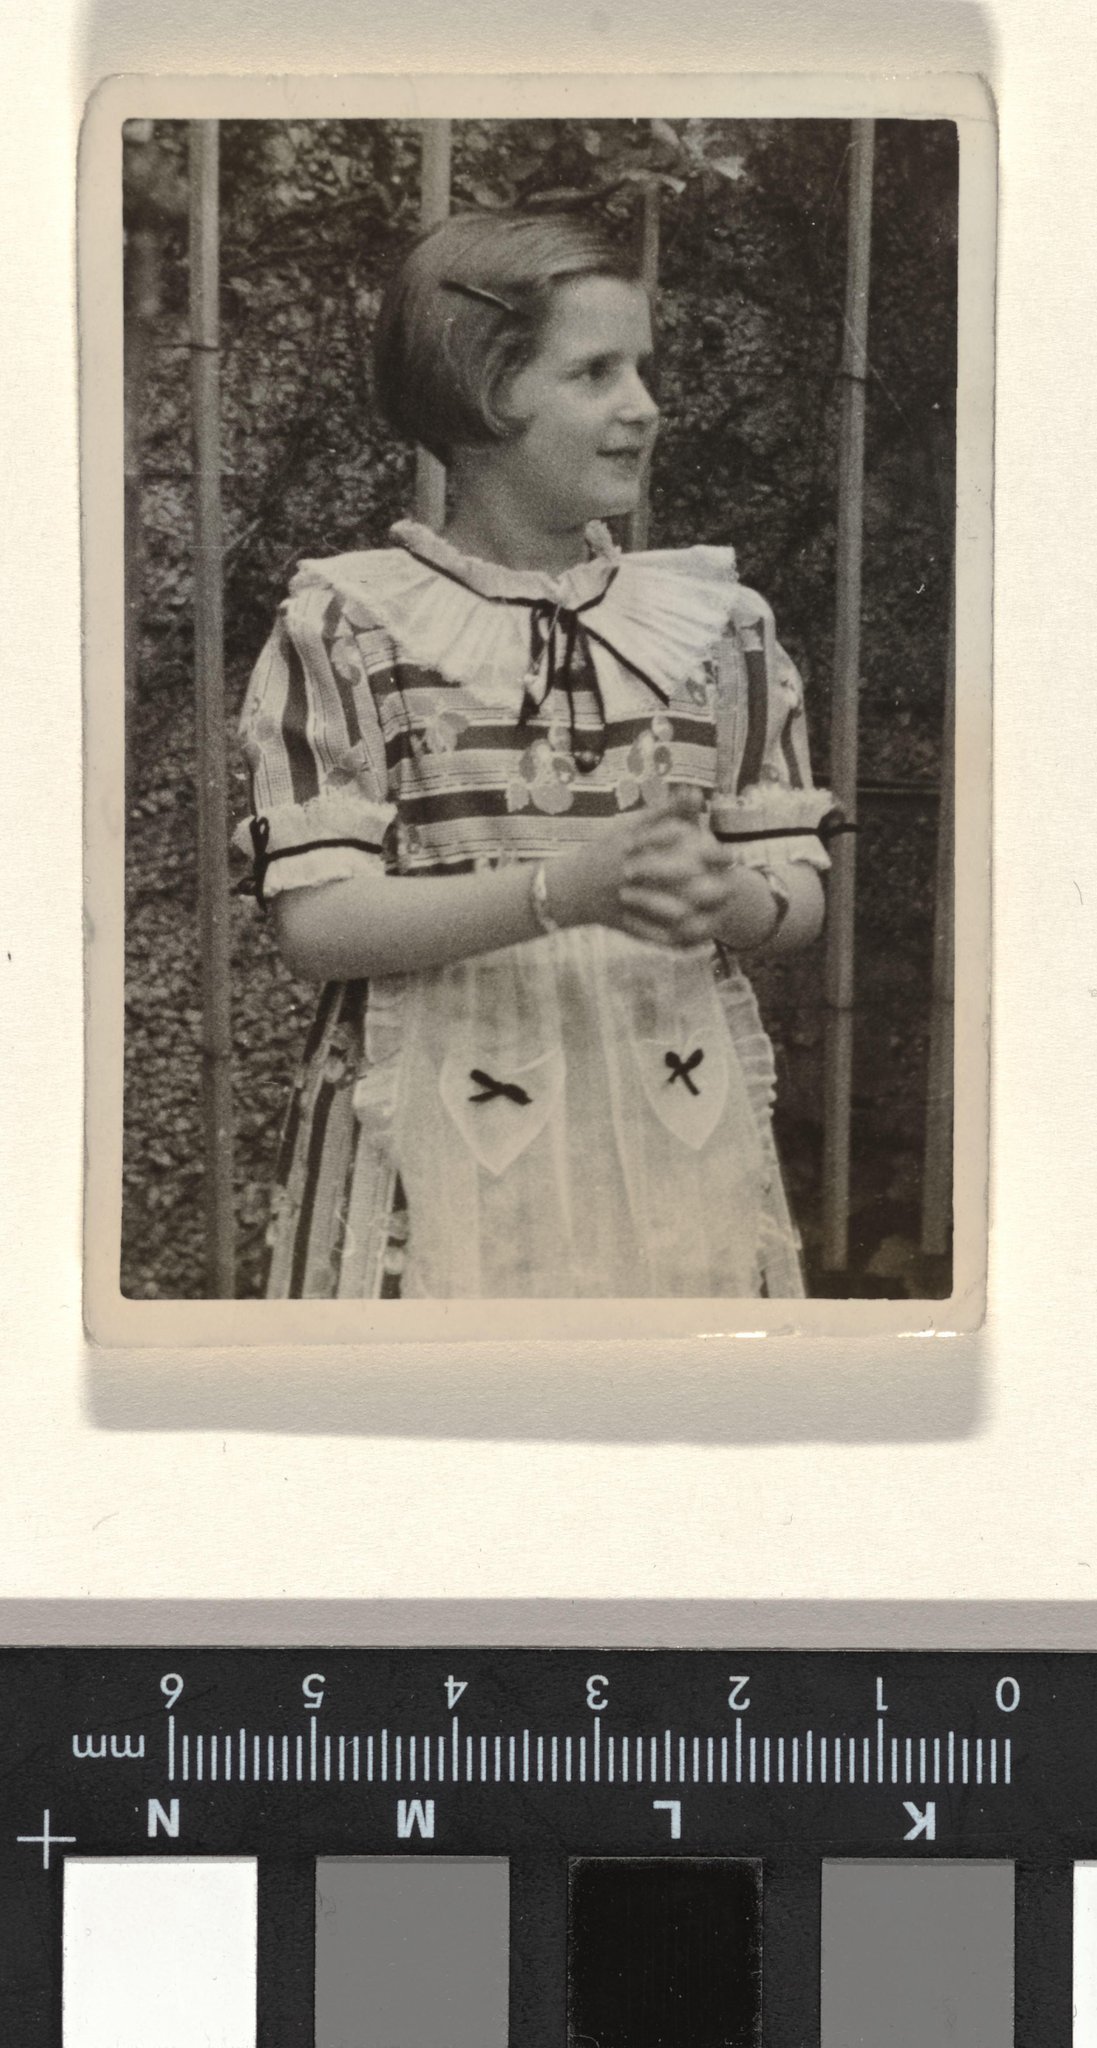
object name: photograph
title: Isabel Wachenheimer in gestreepte jurk voor een hek op Evi's verjaardag, mei-juni 1937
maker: Anonymous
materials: photographic support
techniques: gelatin silver print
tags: leiden, isabel wachenheimer-elon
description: Isabel Wachenheimer in gestreepte jurk voor een hek.